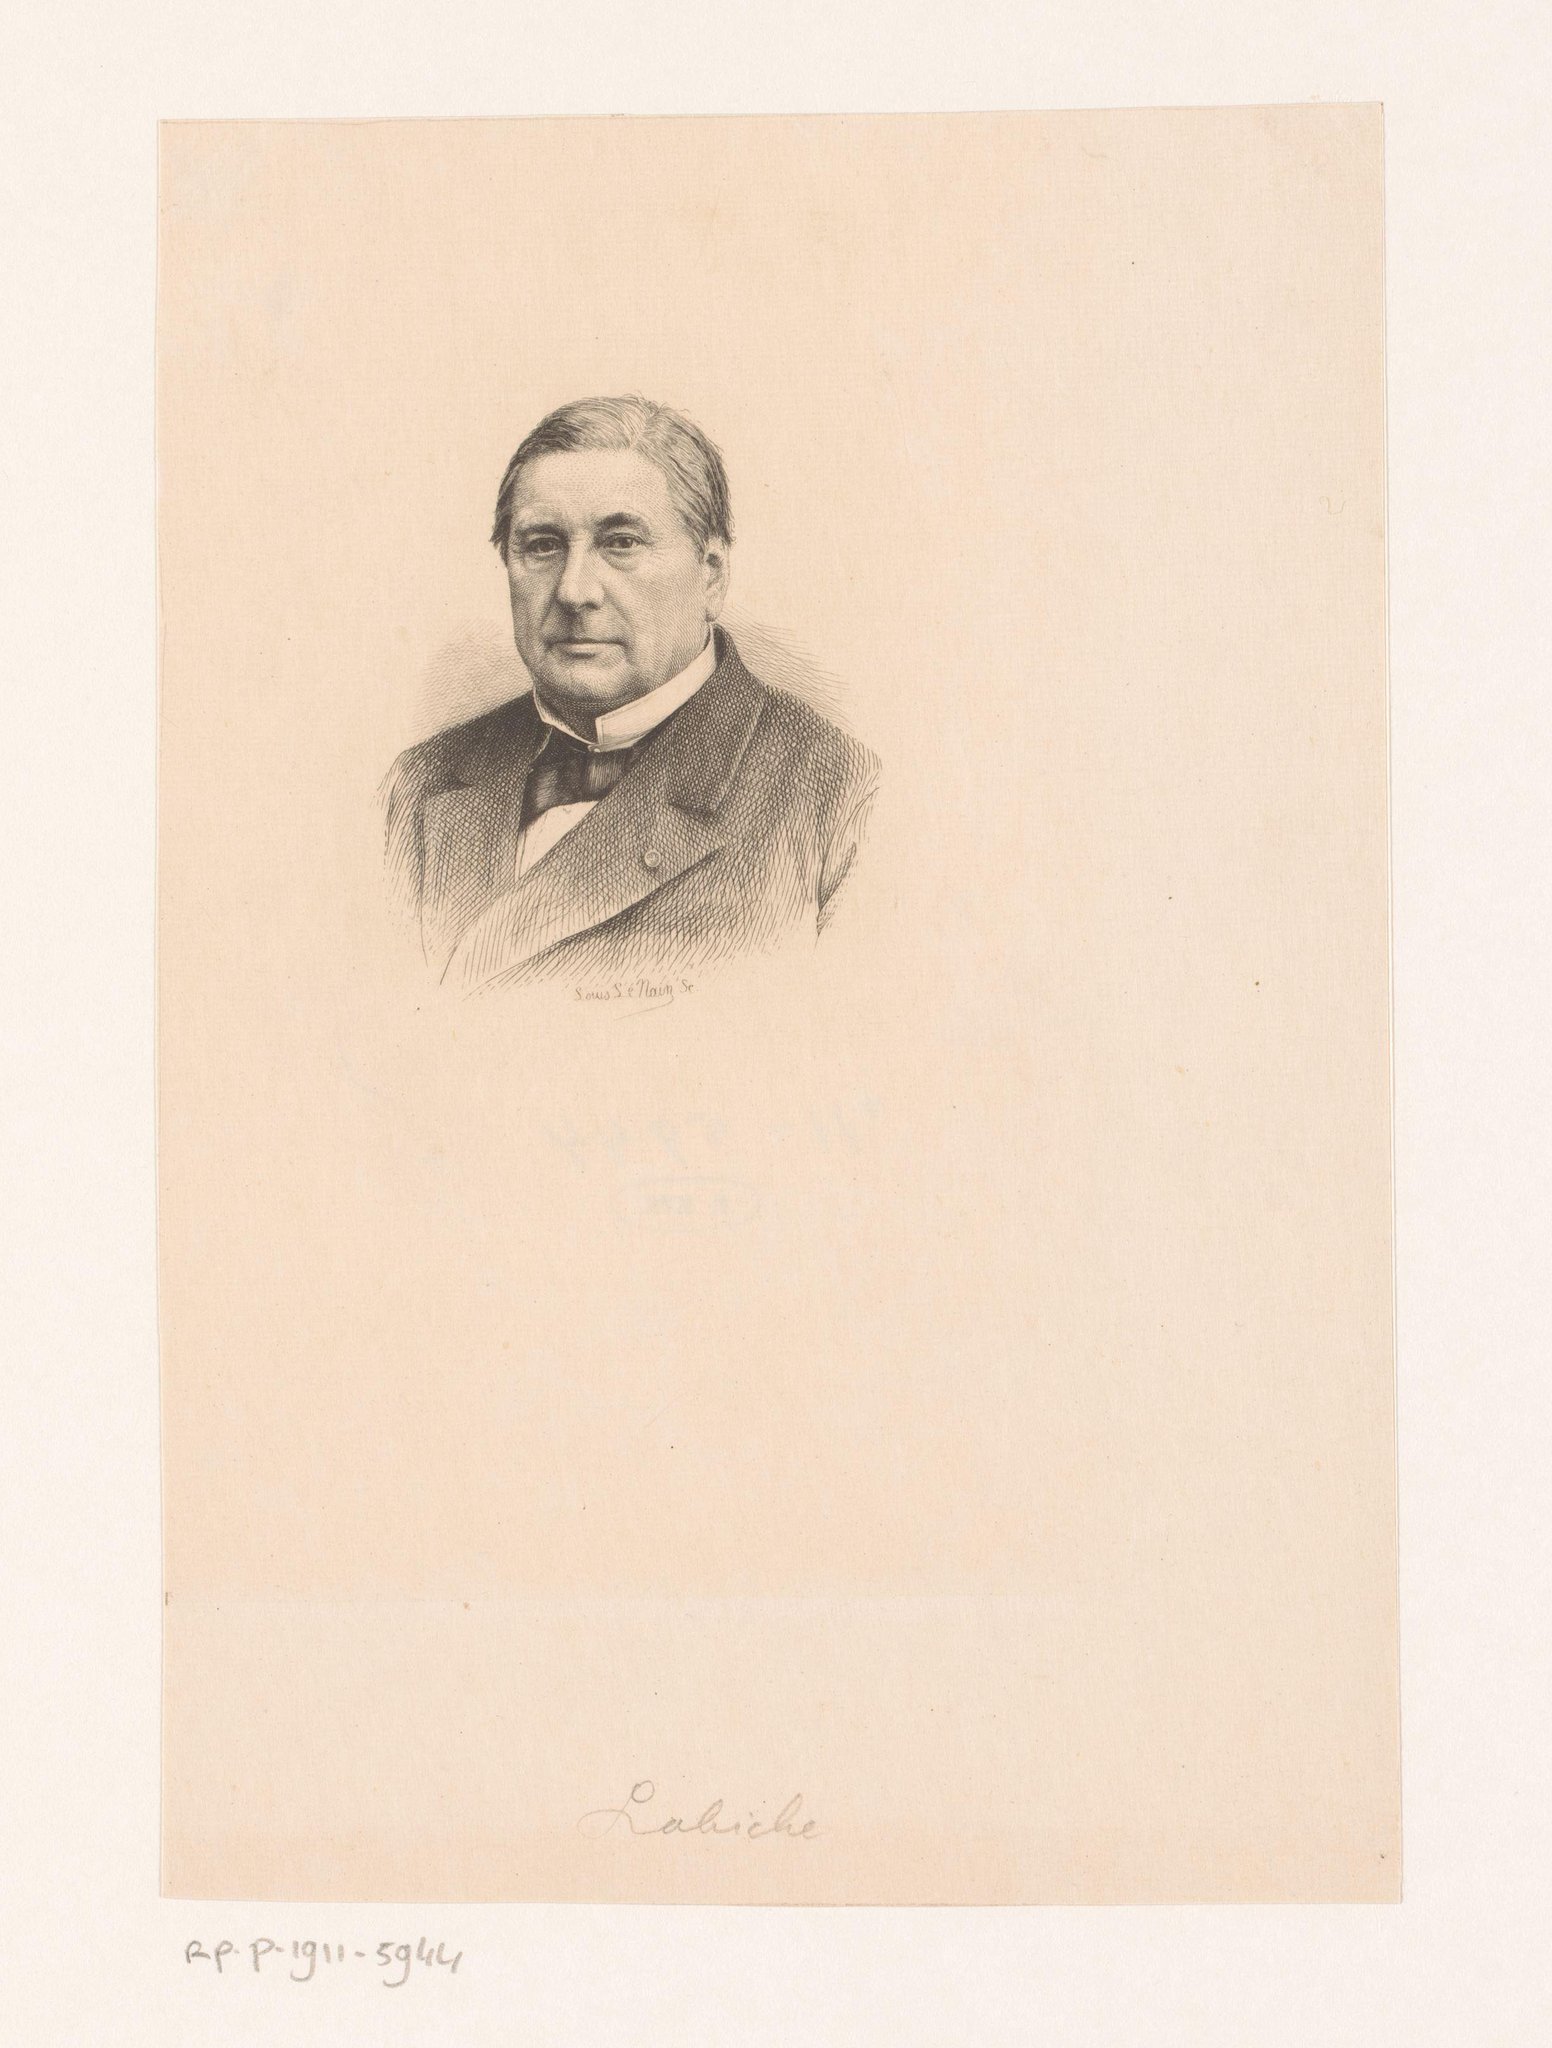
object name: print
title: Portret van Eugène Labiche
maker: louis le nain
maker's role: print maker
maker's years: 1851-1939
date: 1861-1911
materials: paper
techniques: etching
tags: adult man, historical persons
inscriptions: collector's mark: Lugt 2228